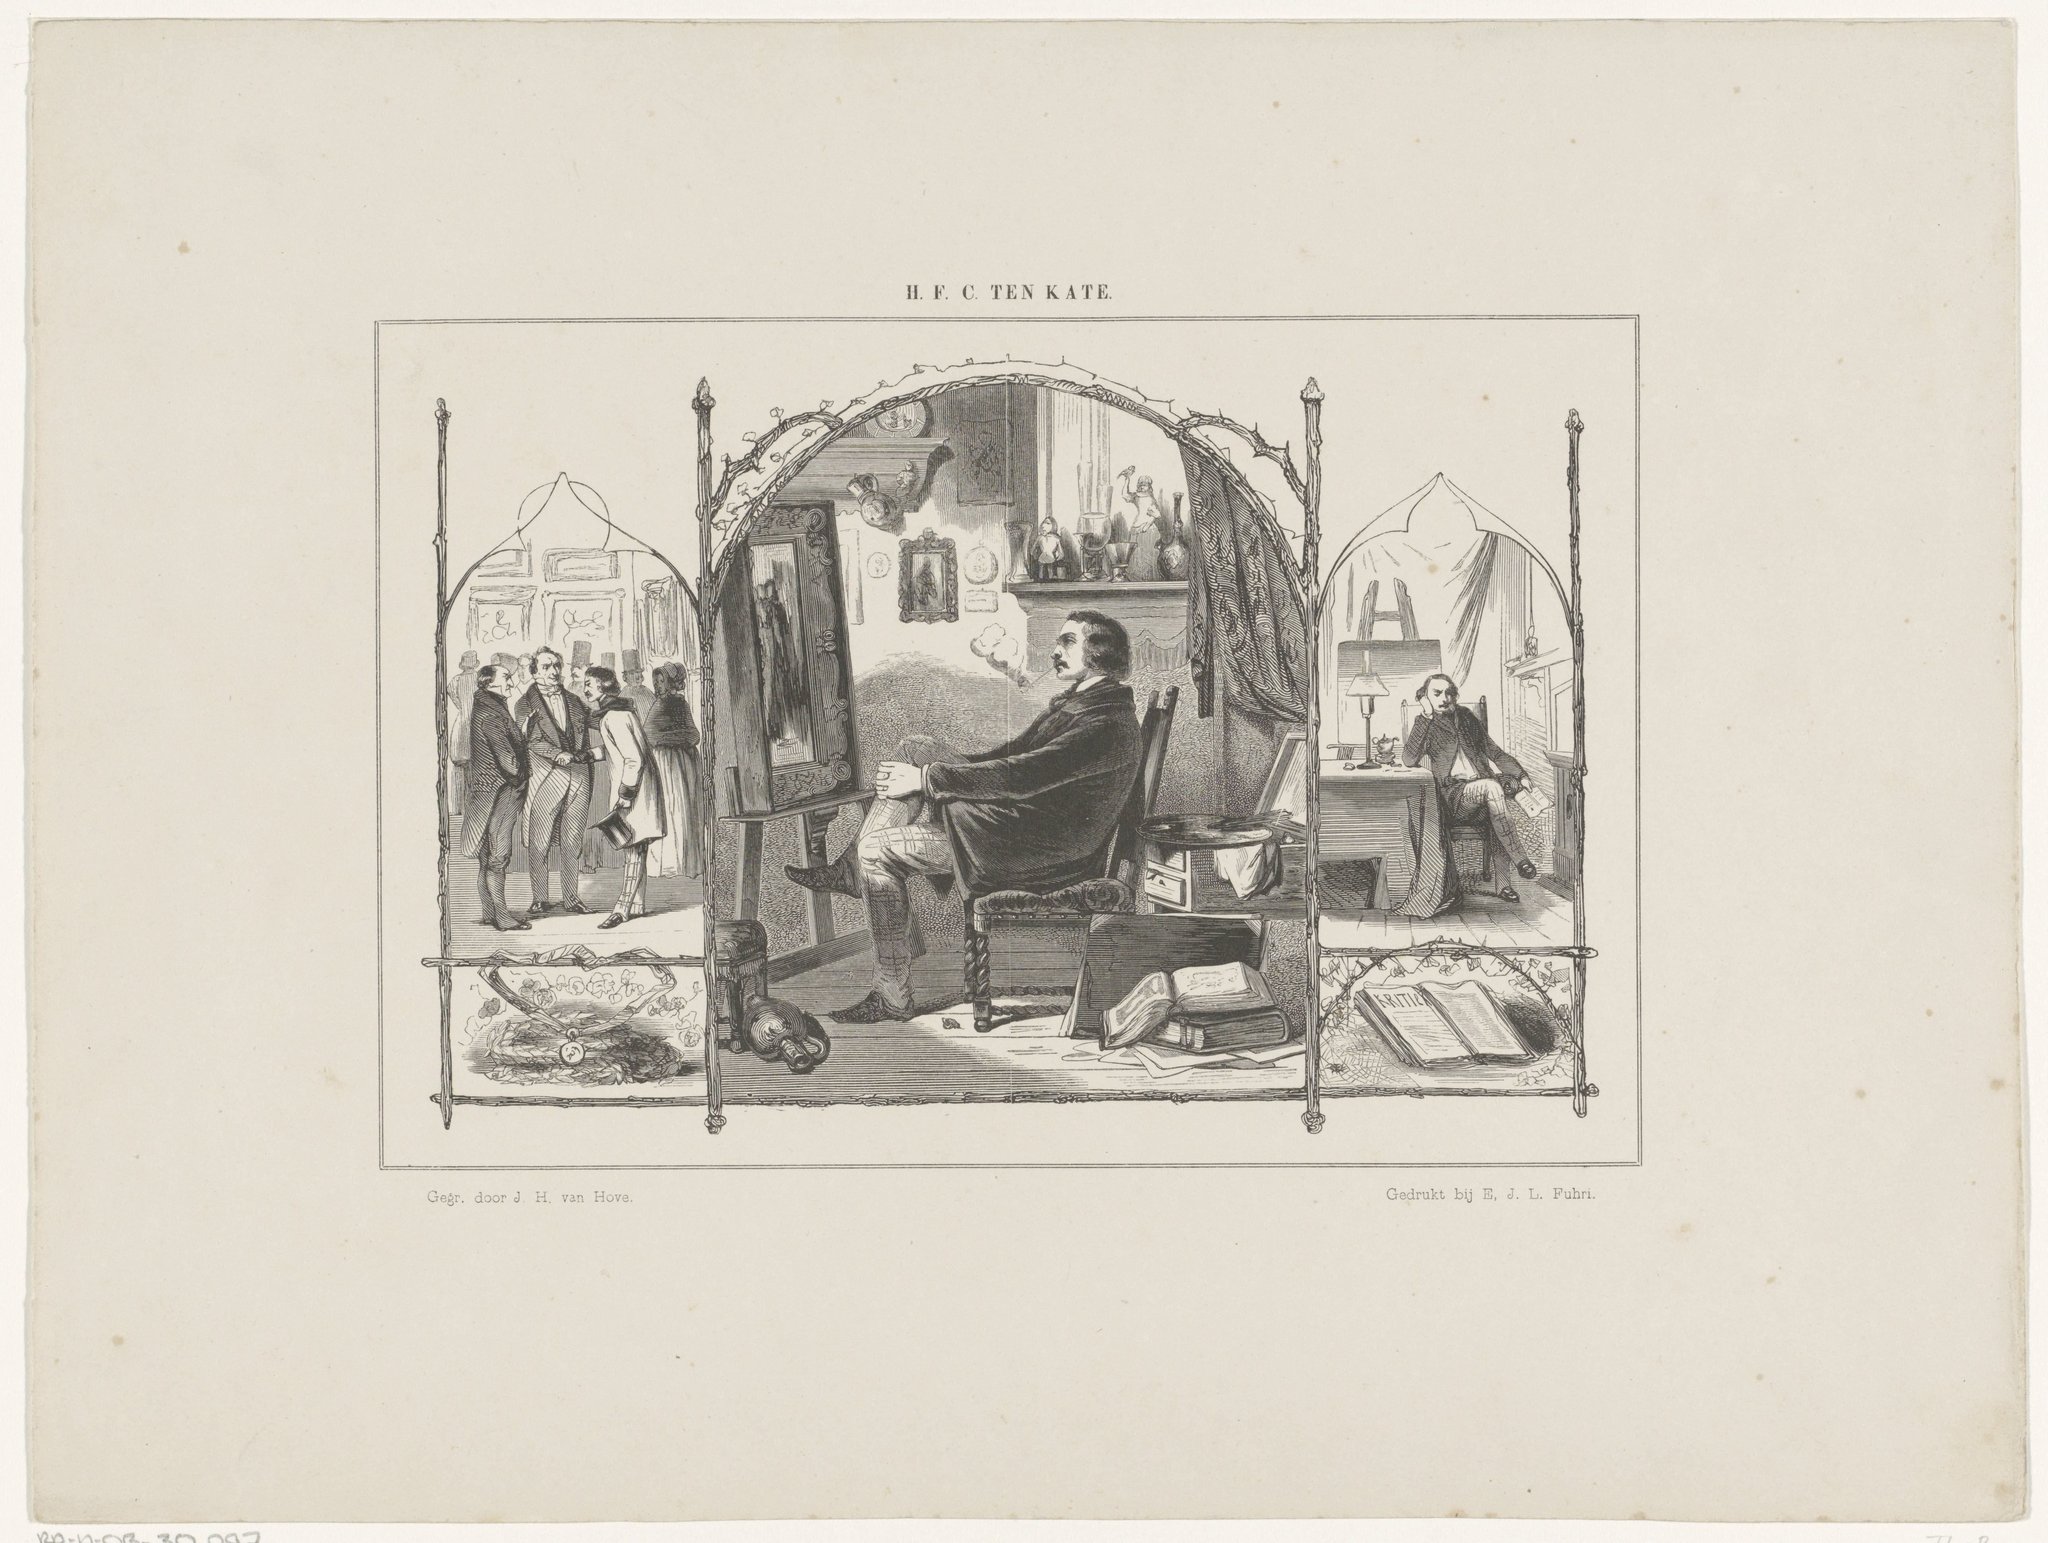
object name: print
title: Drieluik met taferelen uit het leven van een schilder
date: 1837-1881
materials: paper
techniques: engraving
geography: the hague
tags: criticizing and discussing art, art criticism, art collection, art gallery, painter at work, in his studio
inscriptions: collector's mark: Lugt 2228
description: In het midden zit een schilder in zijn atelier naar zijn eigen werk te kijken. Links staat de schilder in een atelier handen te schudden met een aantal mannen. Rechts zit de schilder de kritieken die op zijn werk geleverd zijn te lezen.